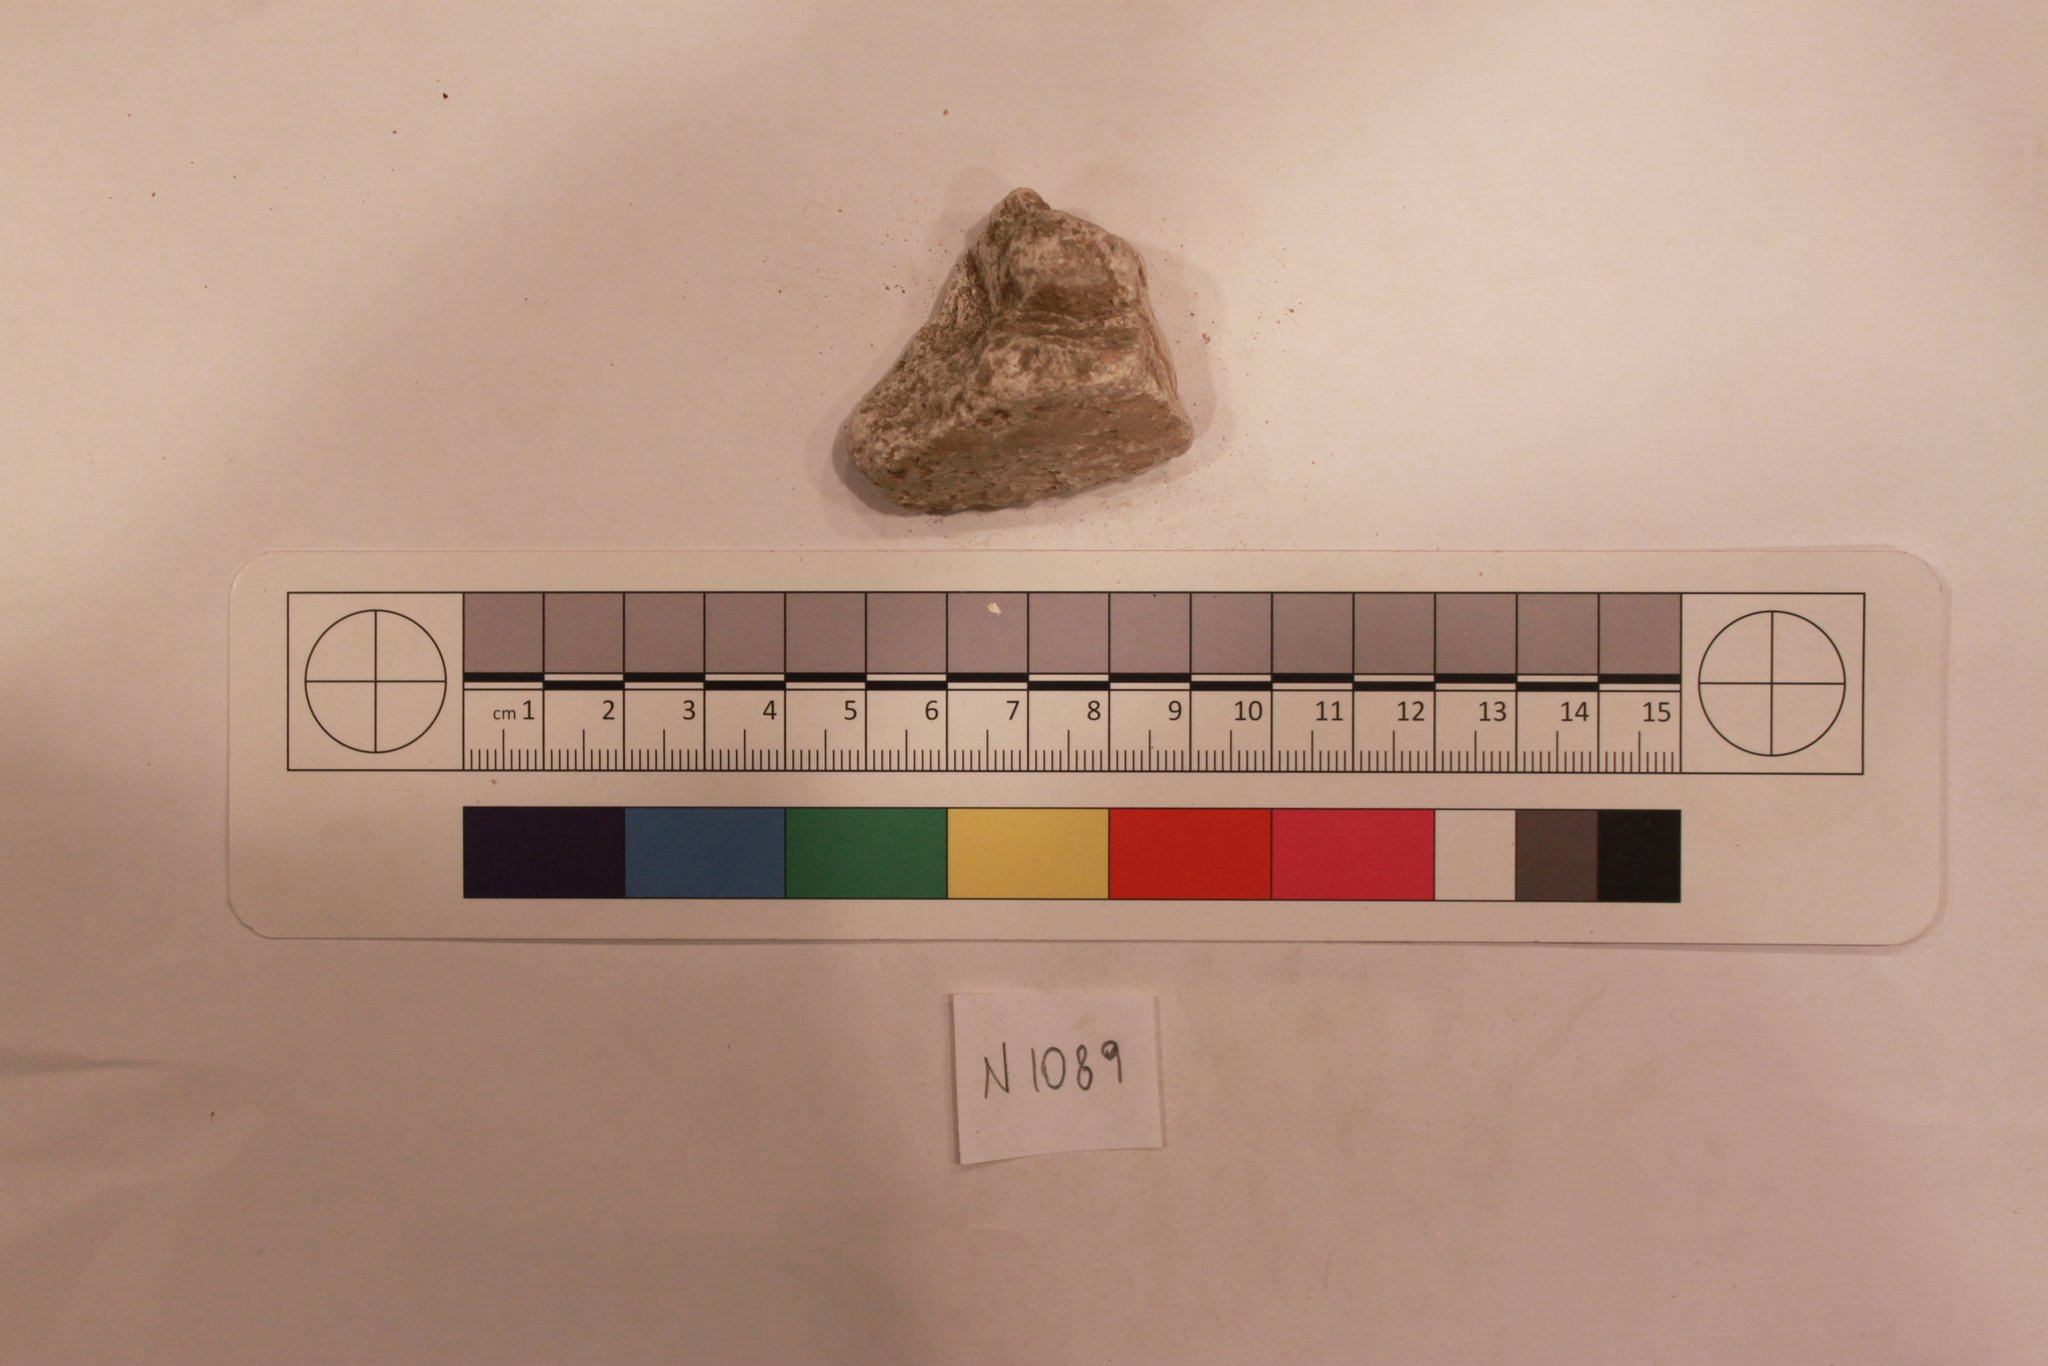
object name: fragment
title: Stucco Fragment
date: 701-1200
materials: plaster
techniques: carving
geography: iran